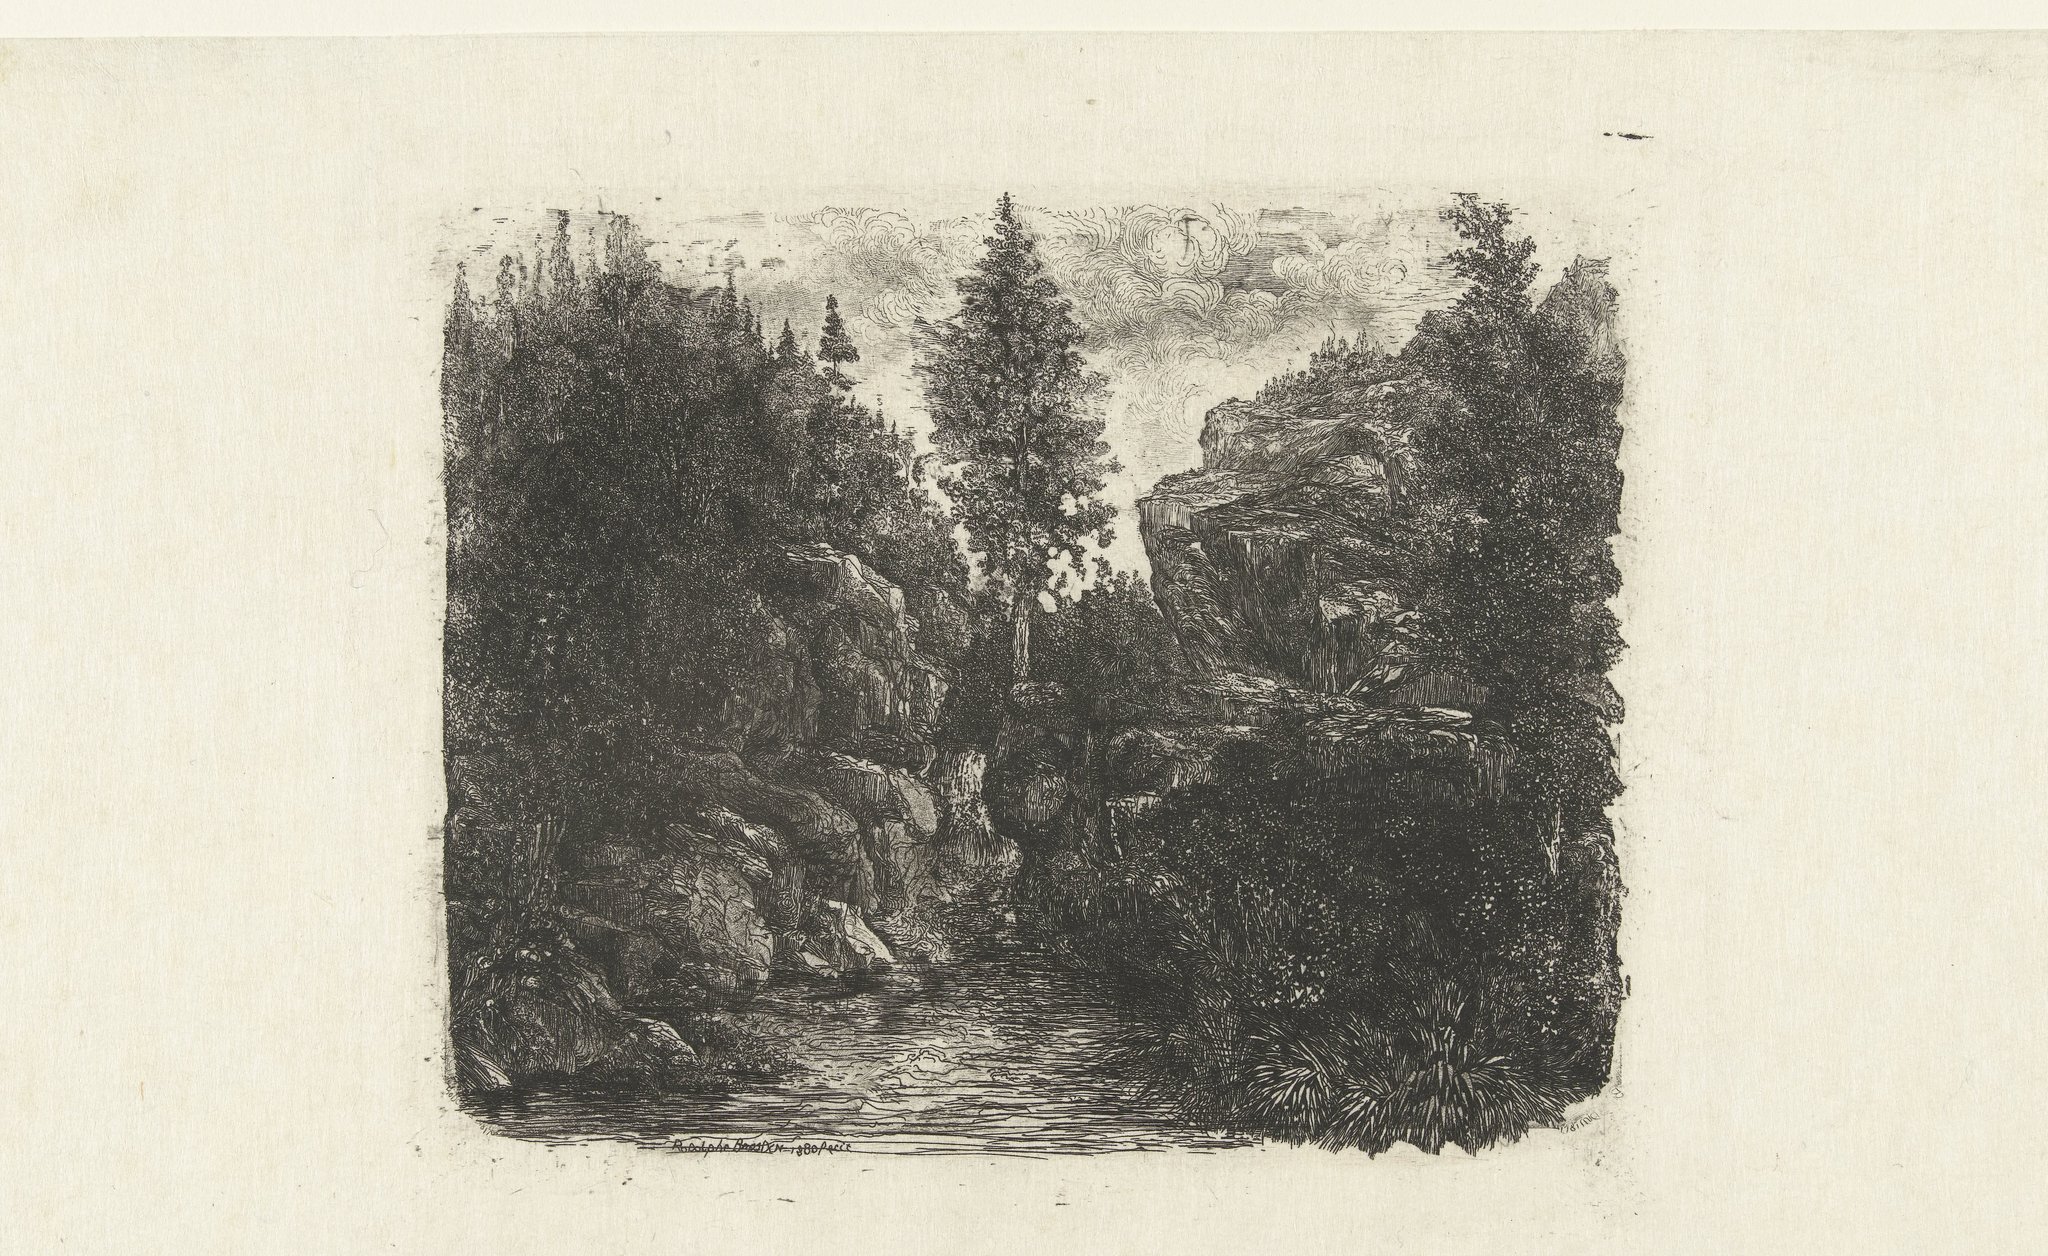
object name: print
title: Paysage rocheux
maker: rodolphe bresdin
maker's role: draughtsman, print maker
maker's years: 1822-1885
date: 1880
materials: paper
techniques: etching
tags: water course, rocks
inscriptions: collector's mark: Lugt 2228, collector's mark: Lugt 76